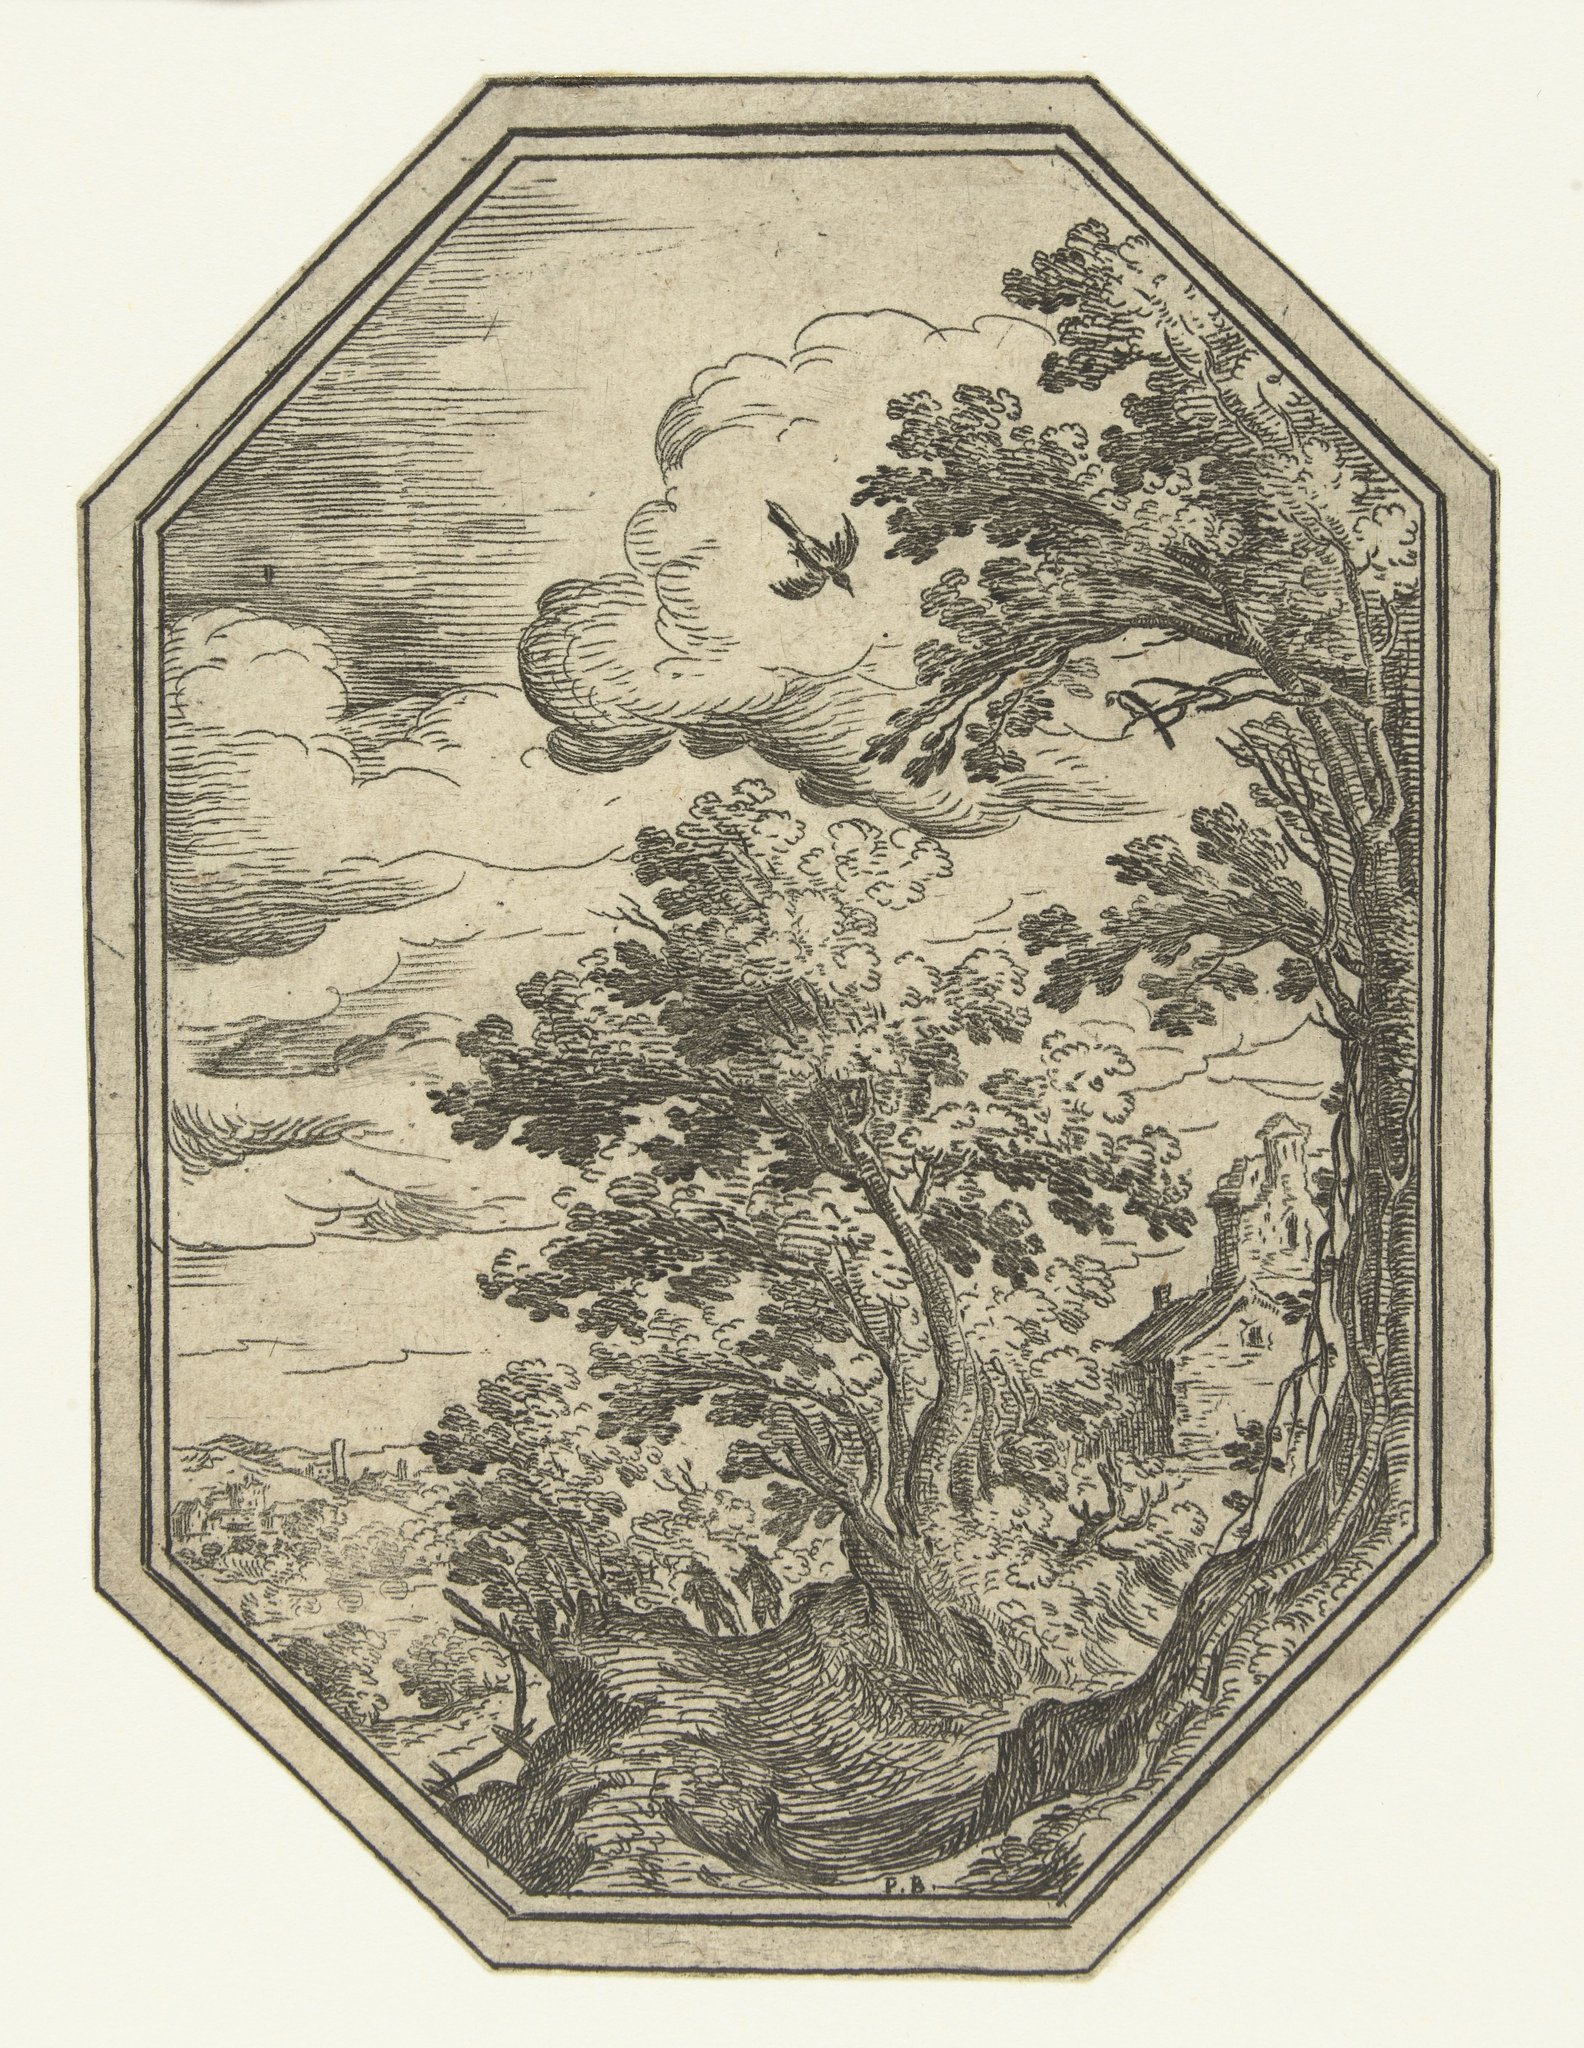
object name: print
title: Octagonale Landschappen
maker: paul bril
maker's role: draughtsman, print maker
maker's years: 1554-1626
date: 1582-1626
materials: paper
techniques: etching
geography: rome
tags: (high) hill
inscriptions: collector's mark: Lugt 2228a